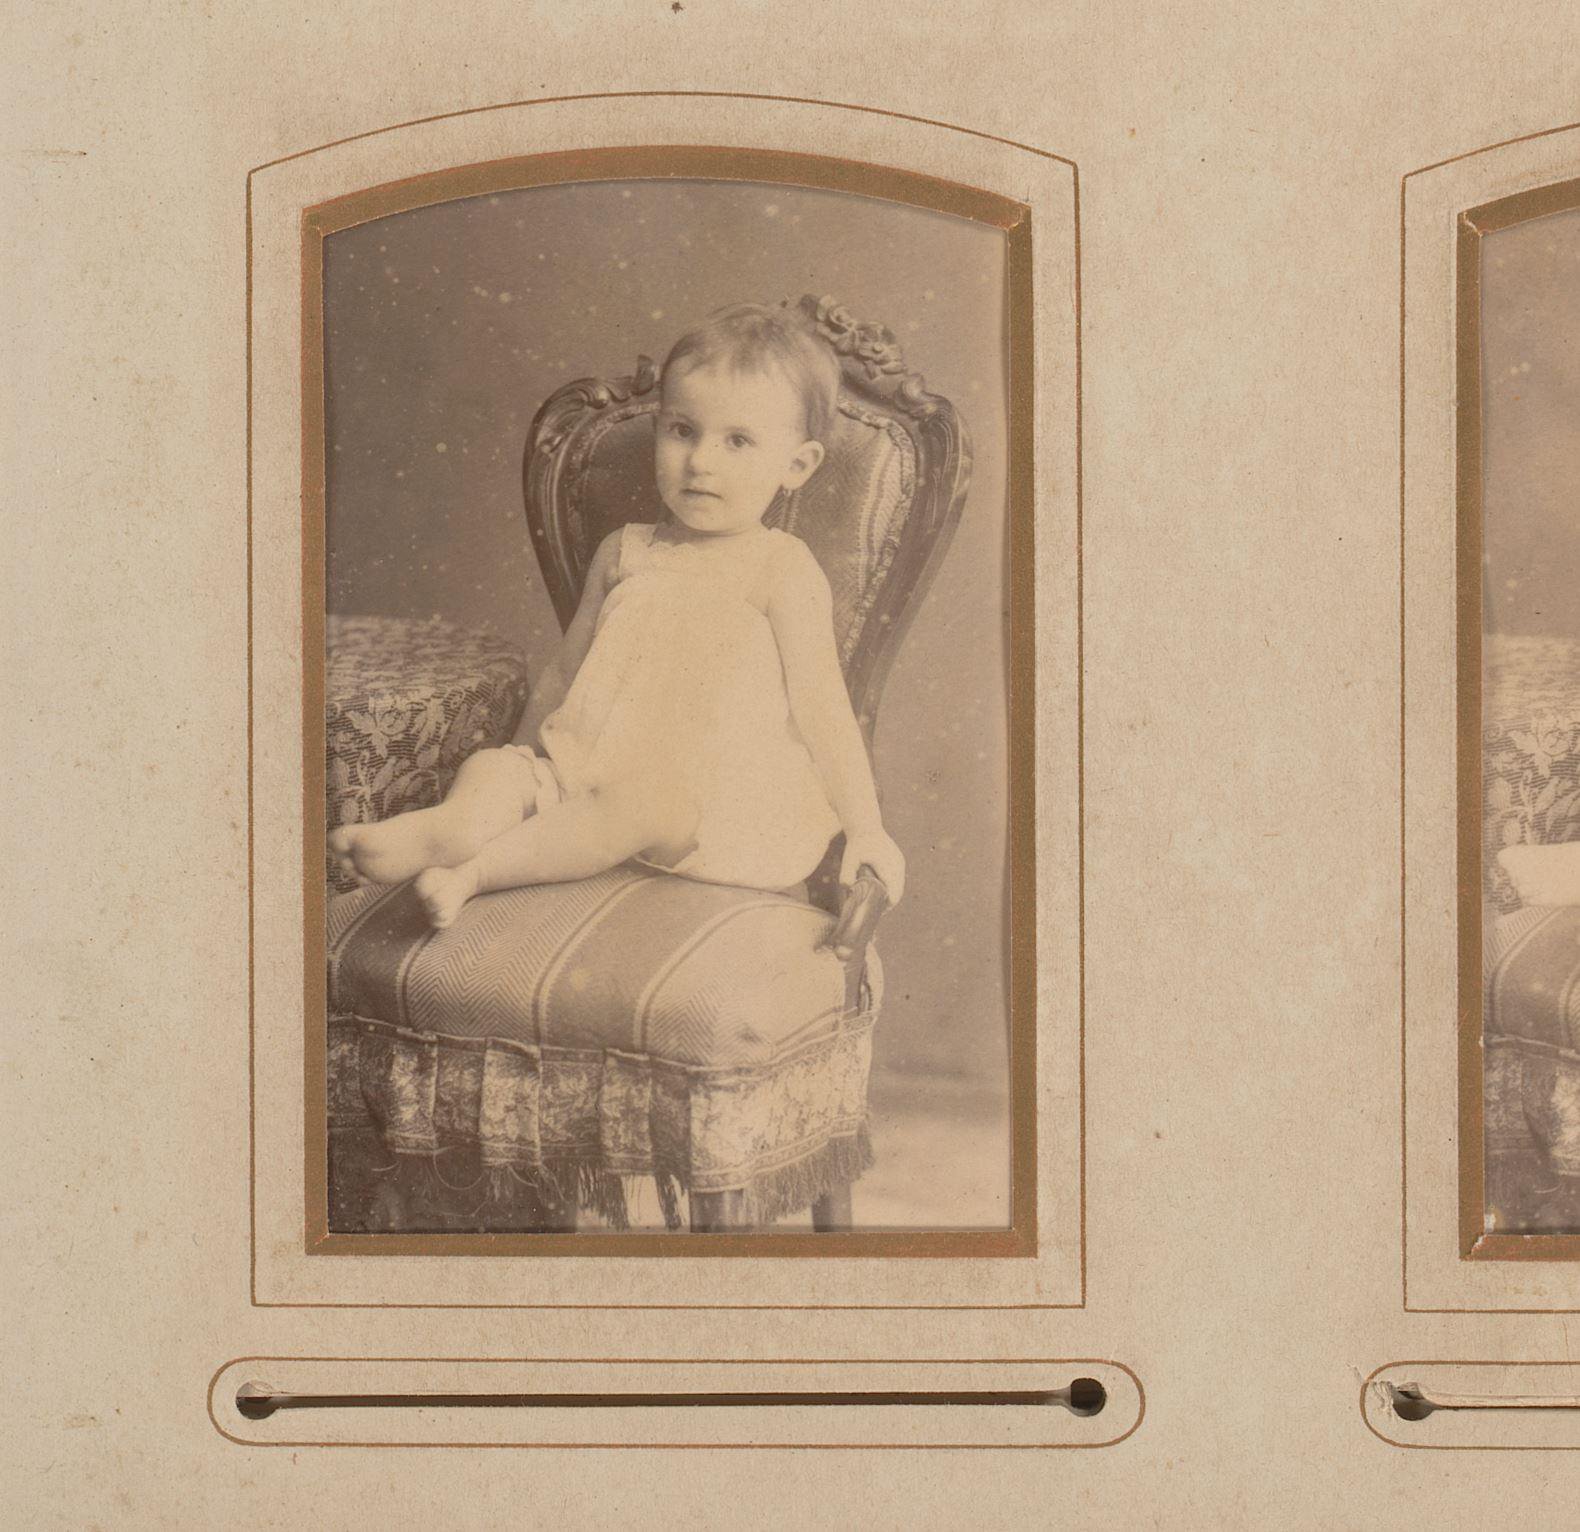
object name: album leaf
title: Portret van een zittend meisje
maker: herman salzwedel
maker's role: fotograaf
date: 1880-1905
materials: cardboard, celluloid, photographic support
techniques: albumen print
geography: surabaya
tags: sitting figure - aa - female human figure, historical persons - bb - woman, toddler (female)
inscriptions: inscription: ‘(...)/ ATELIER/ van/ H. SALZWEDEL/ SOERABAYA/ JAVA./ Het cliché blijft voor nabestelling bewaard.’